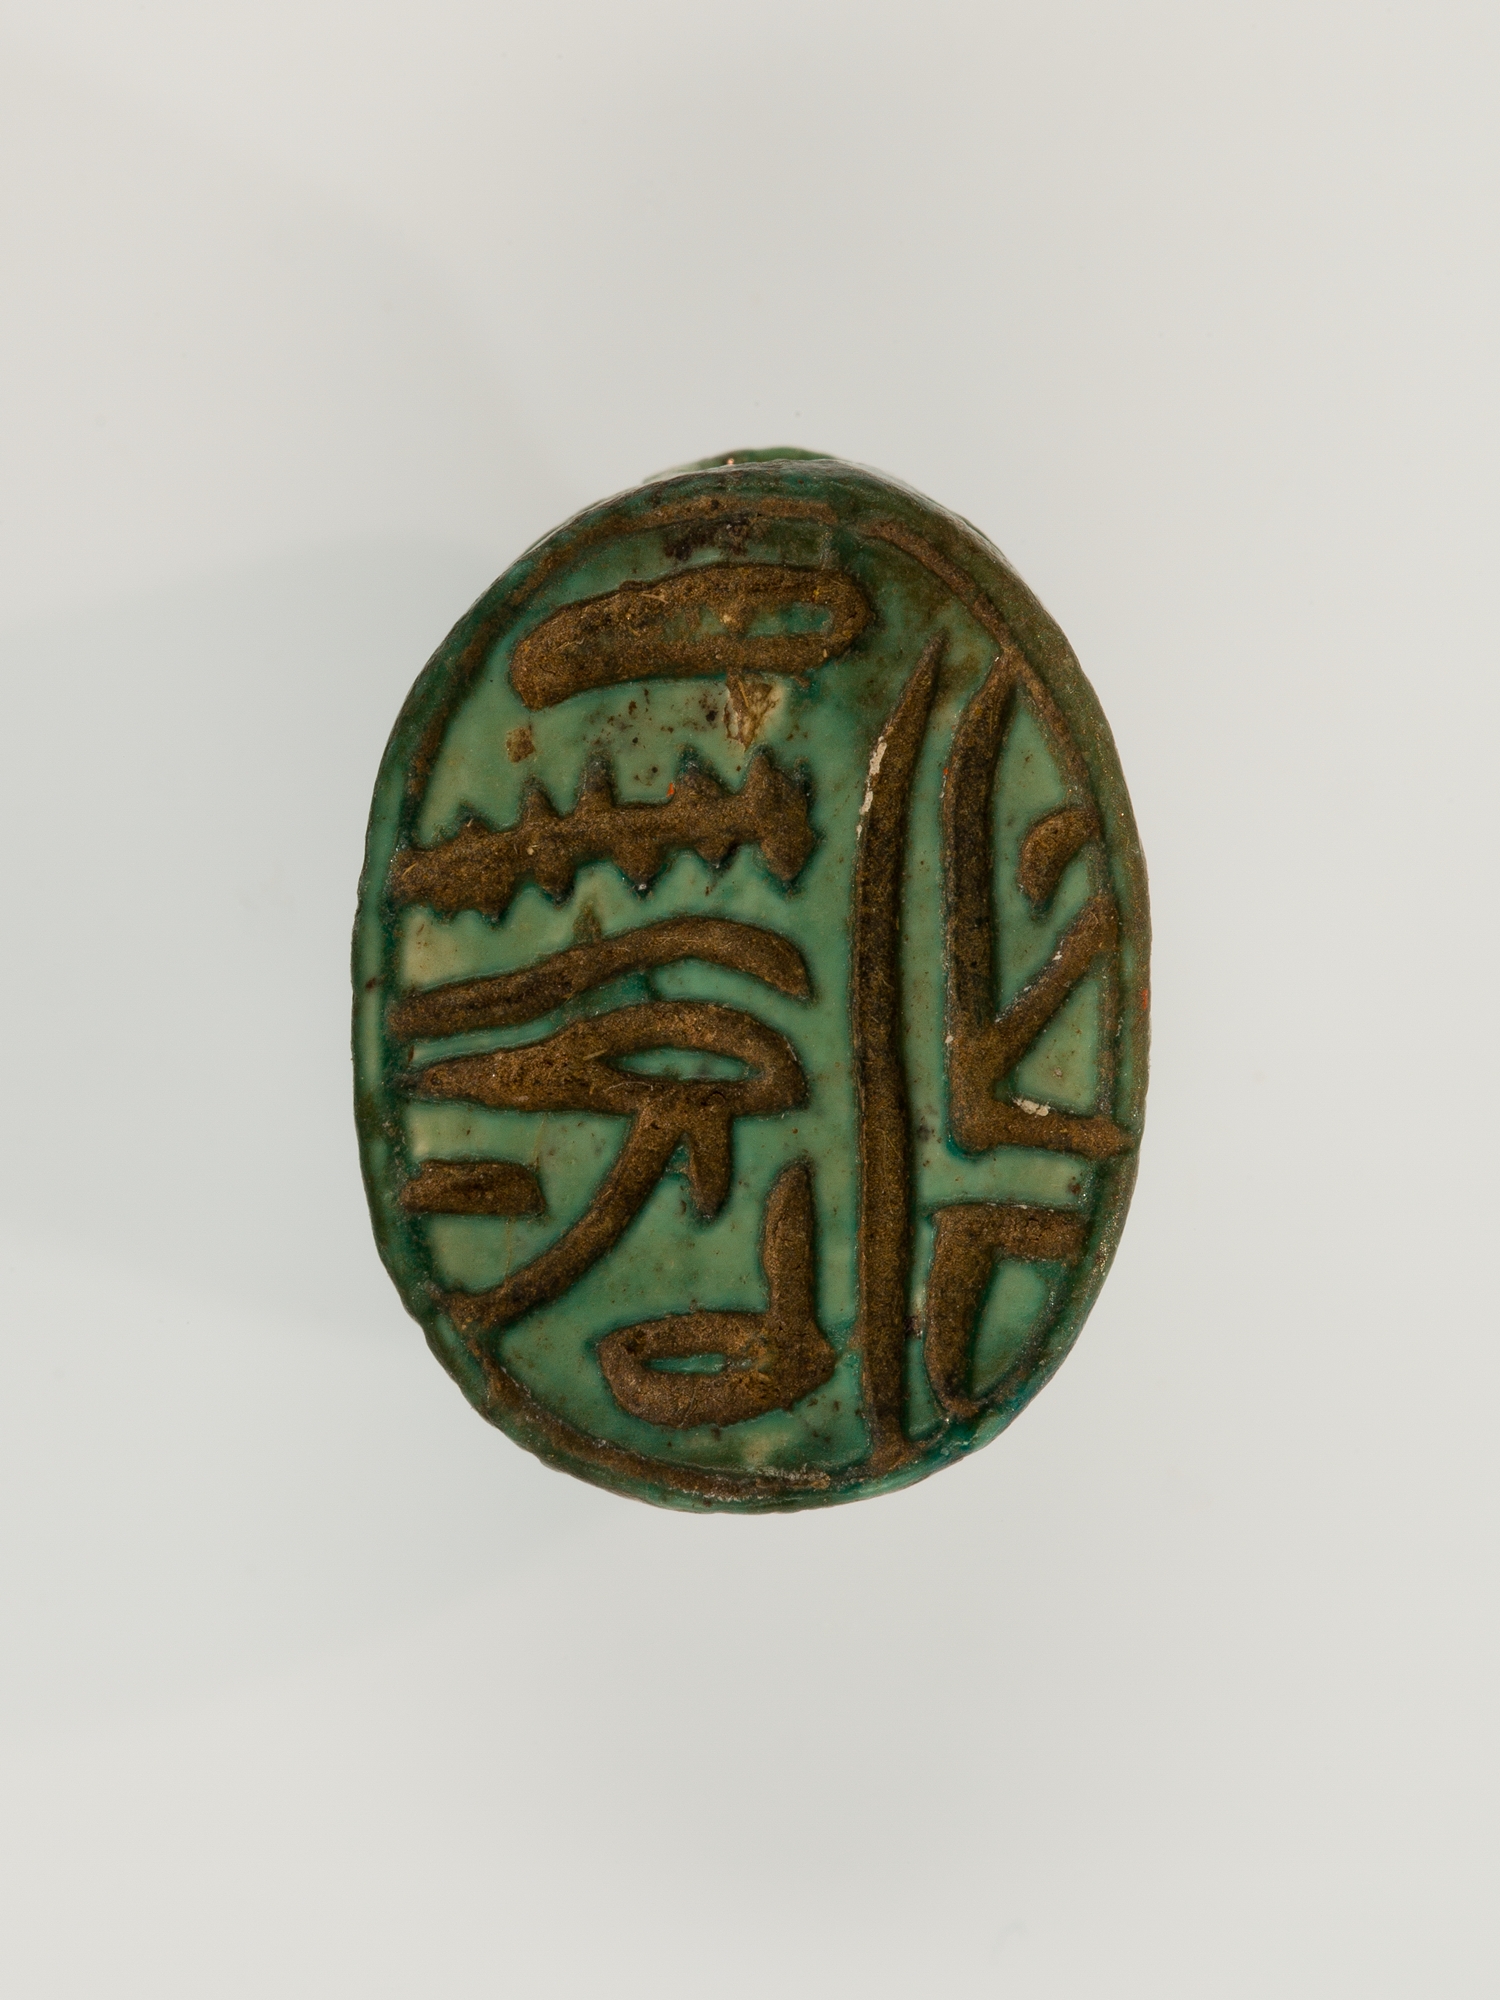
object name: scarab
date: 1295-1070 BCE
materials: stone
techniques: glazing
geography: egypt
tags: hieroglyphs,scarabs